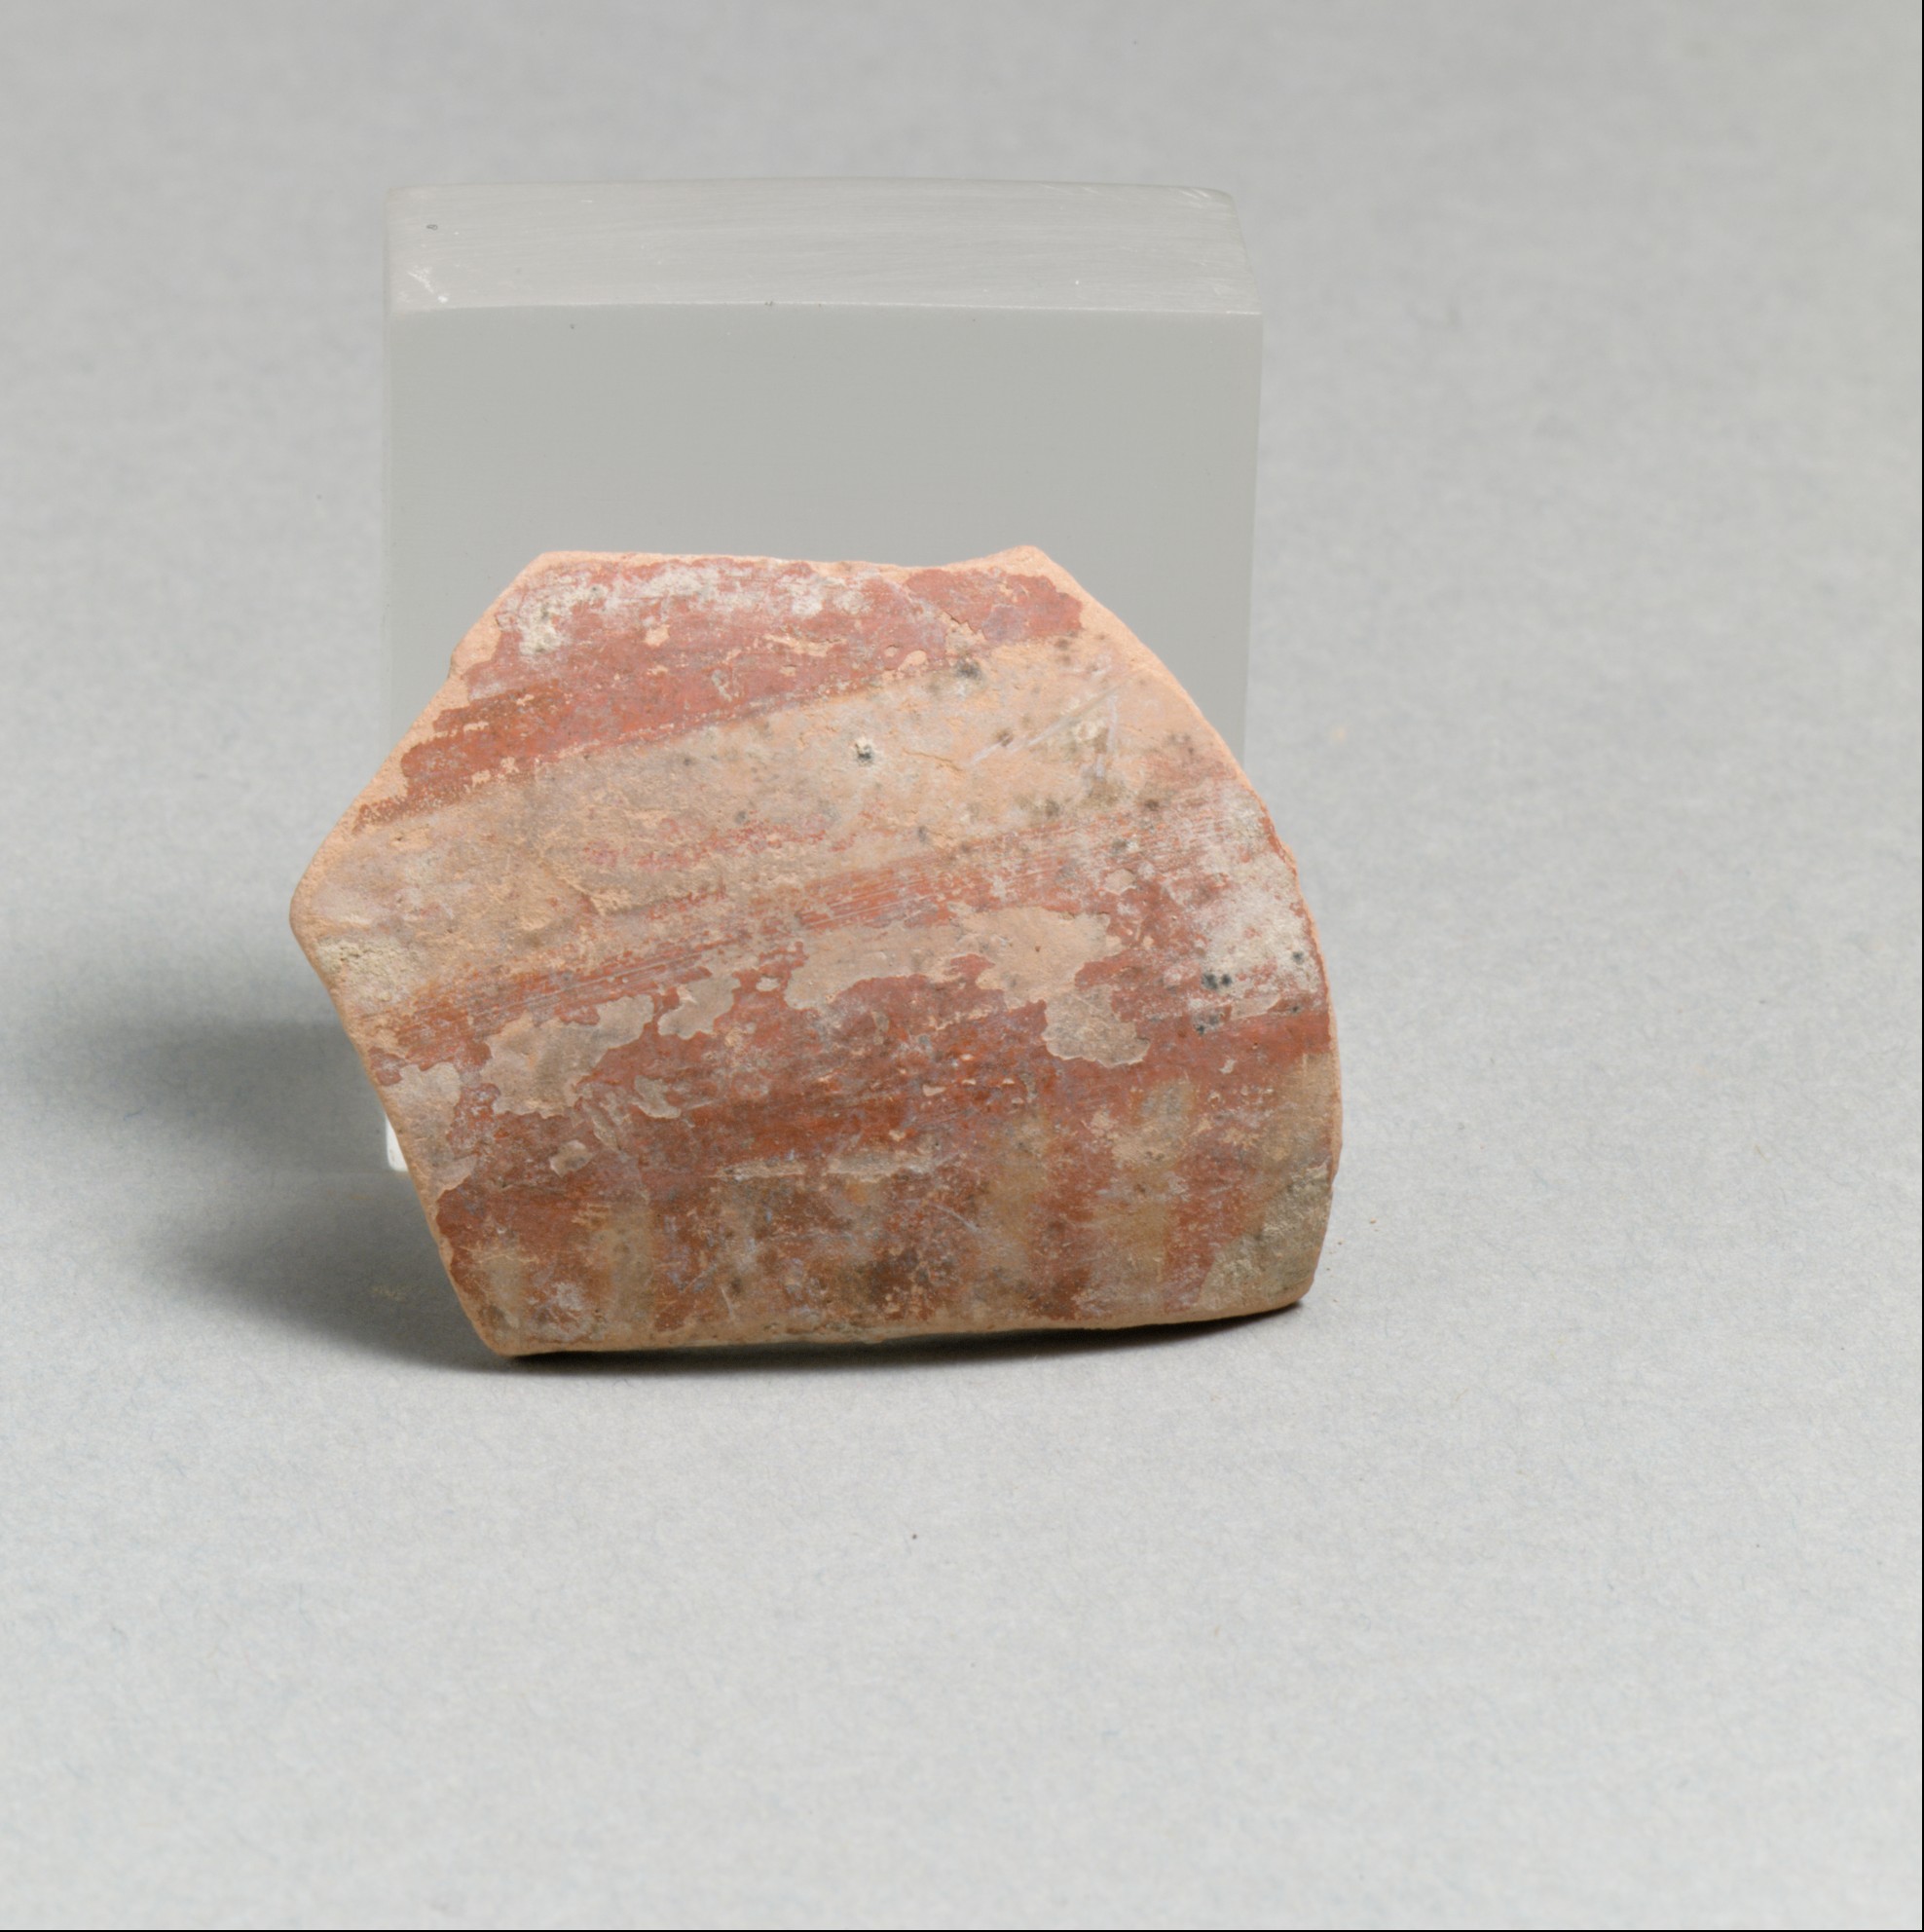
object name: vase fragment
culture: minoan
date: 2600-2000 BCE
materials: terracotta